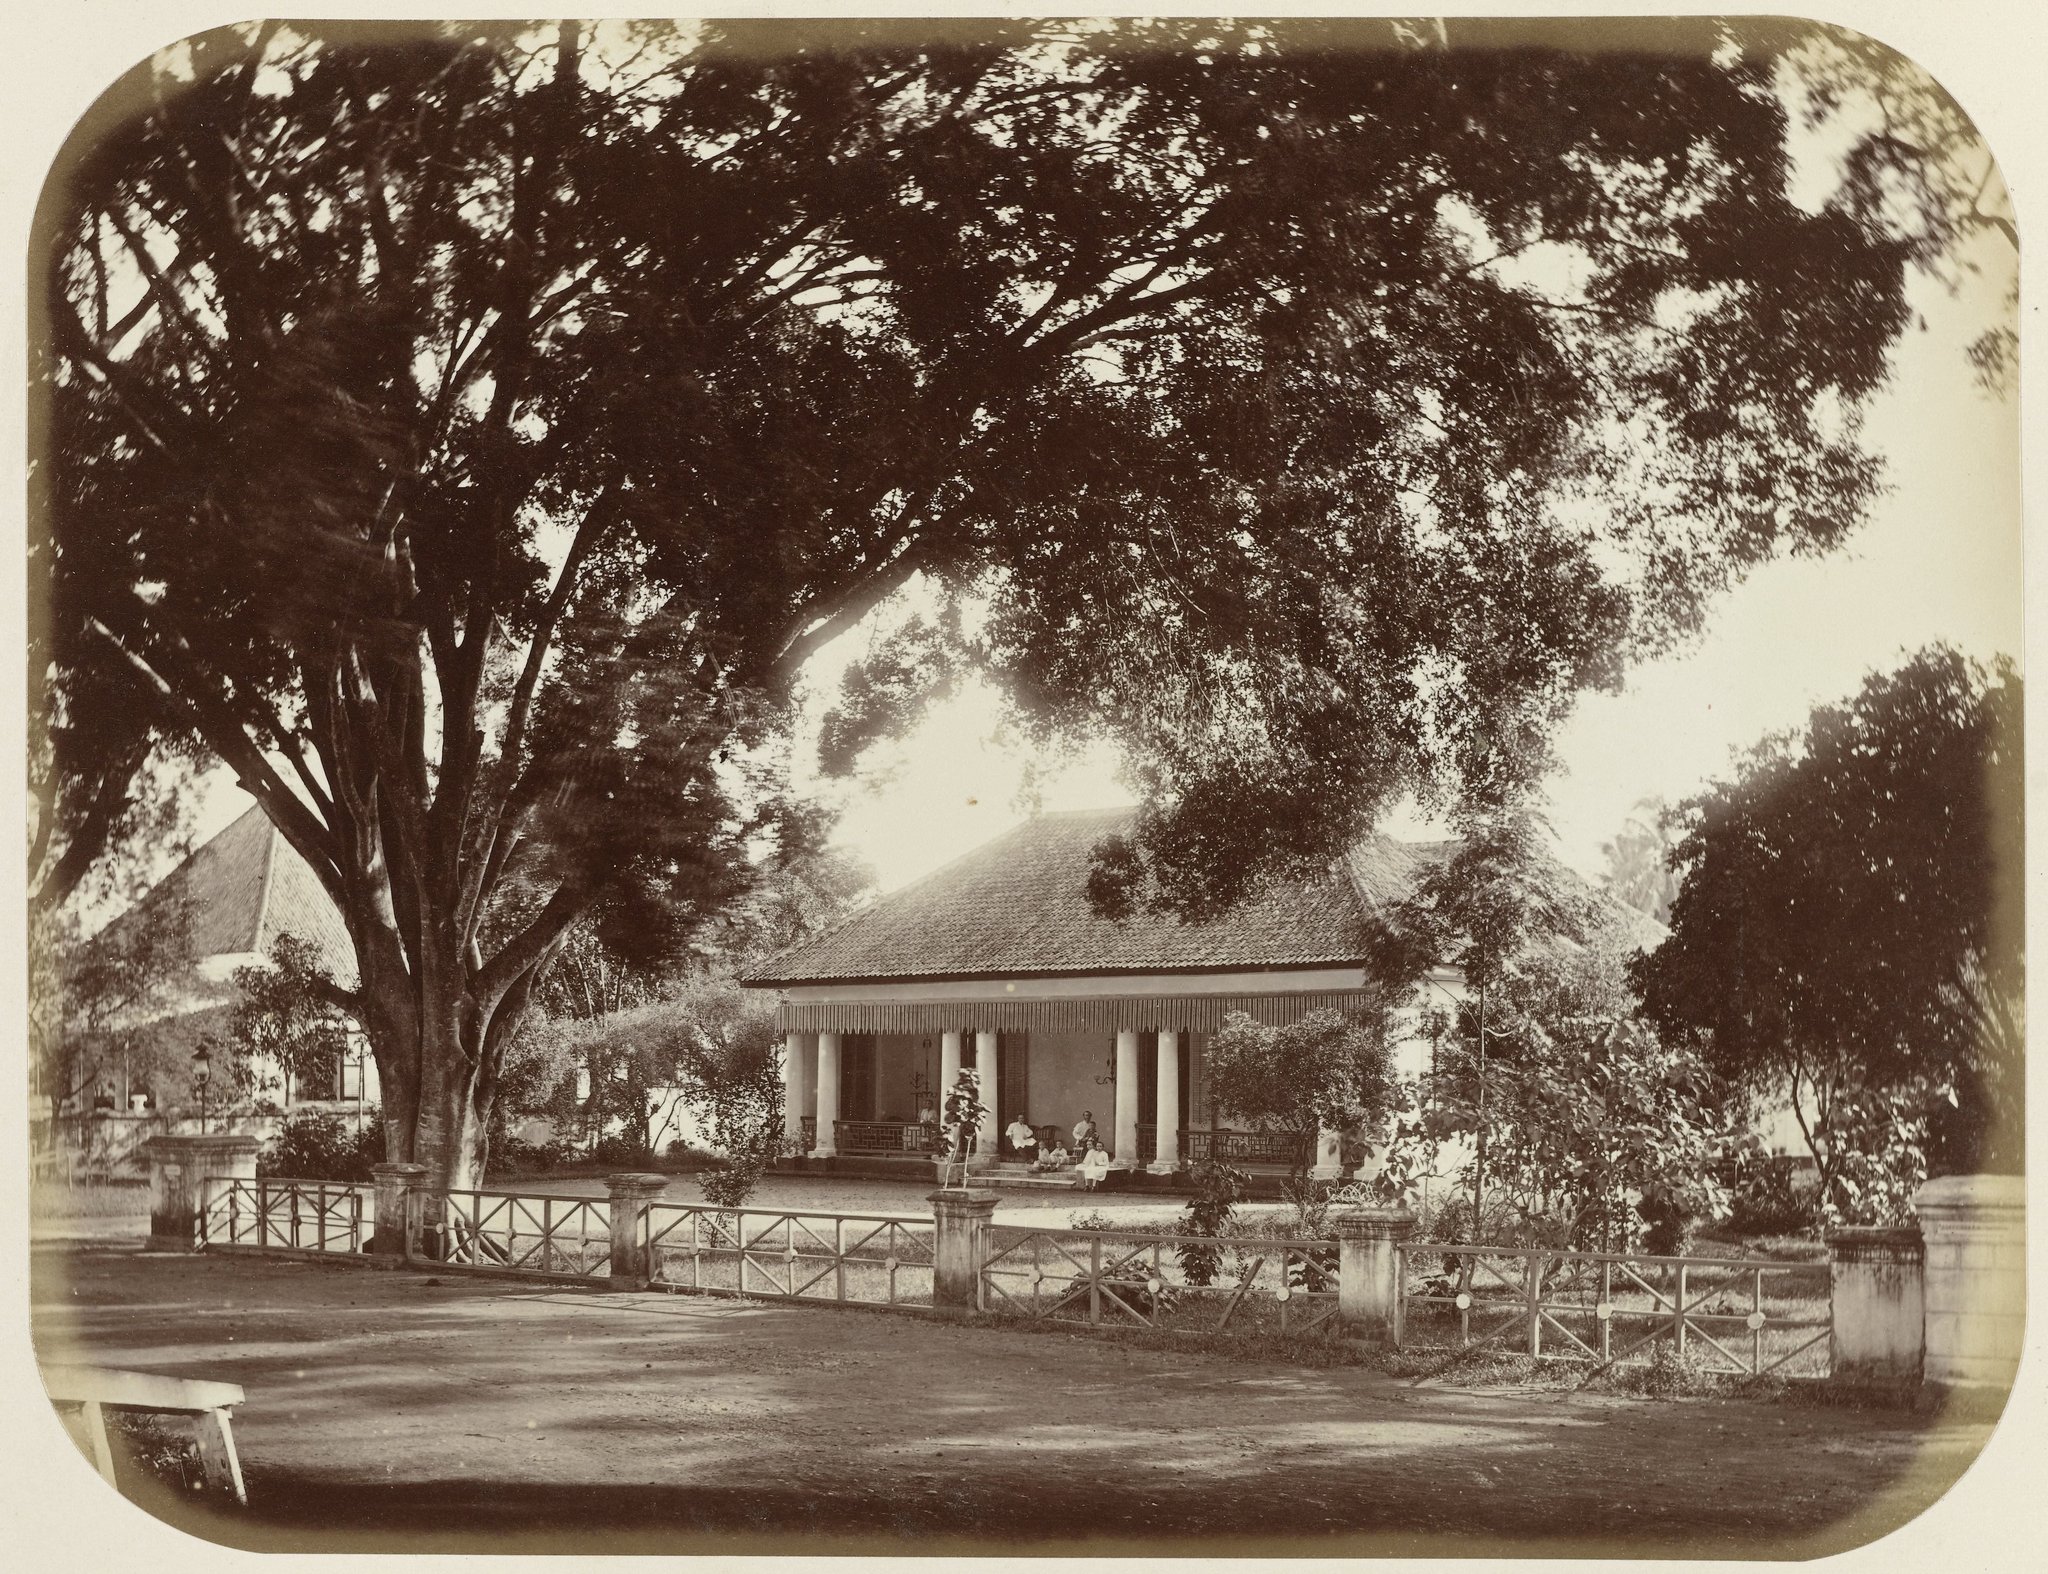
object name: photograph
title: Huis aan de Molenvliet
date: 1870-1879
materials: photographic support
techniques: albumen print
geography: batavia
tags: detached house in city, java, batavia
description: Een huis aan de Molenvliet Oost te Batavia. Voor het huis een zeer grote boom, op de trap zit een gezin met kinderen. Ingeplakte foto in het fotoalbum getiteld: Gezichten van Java.